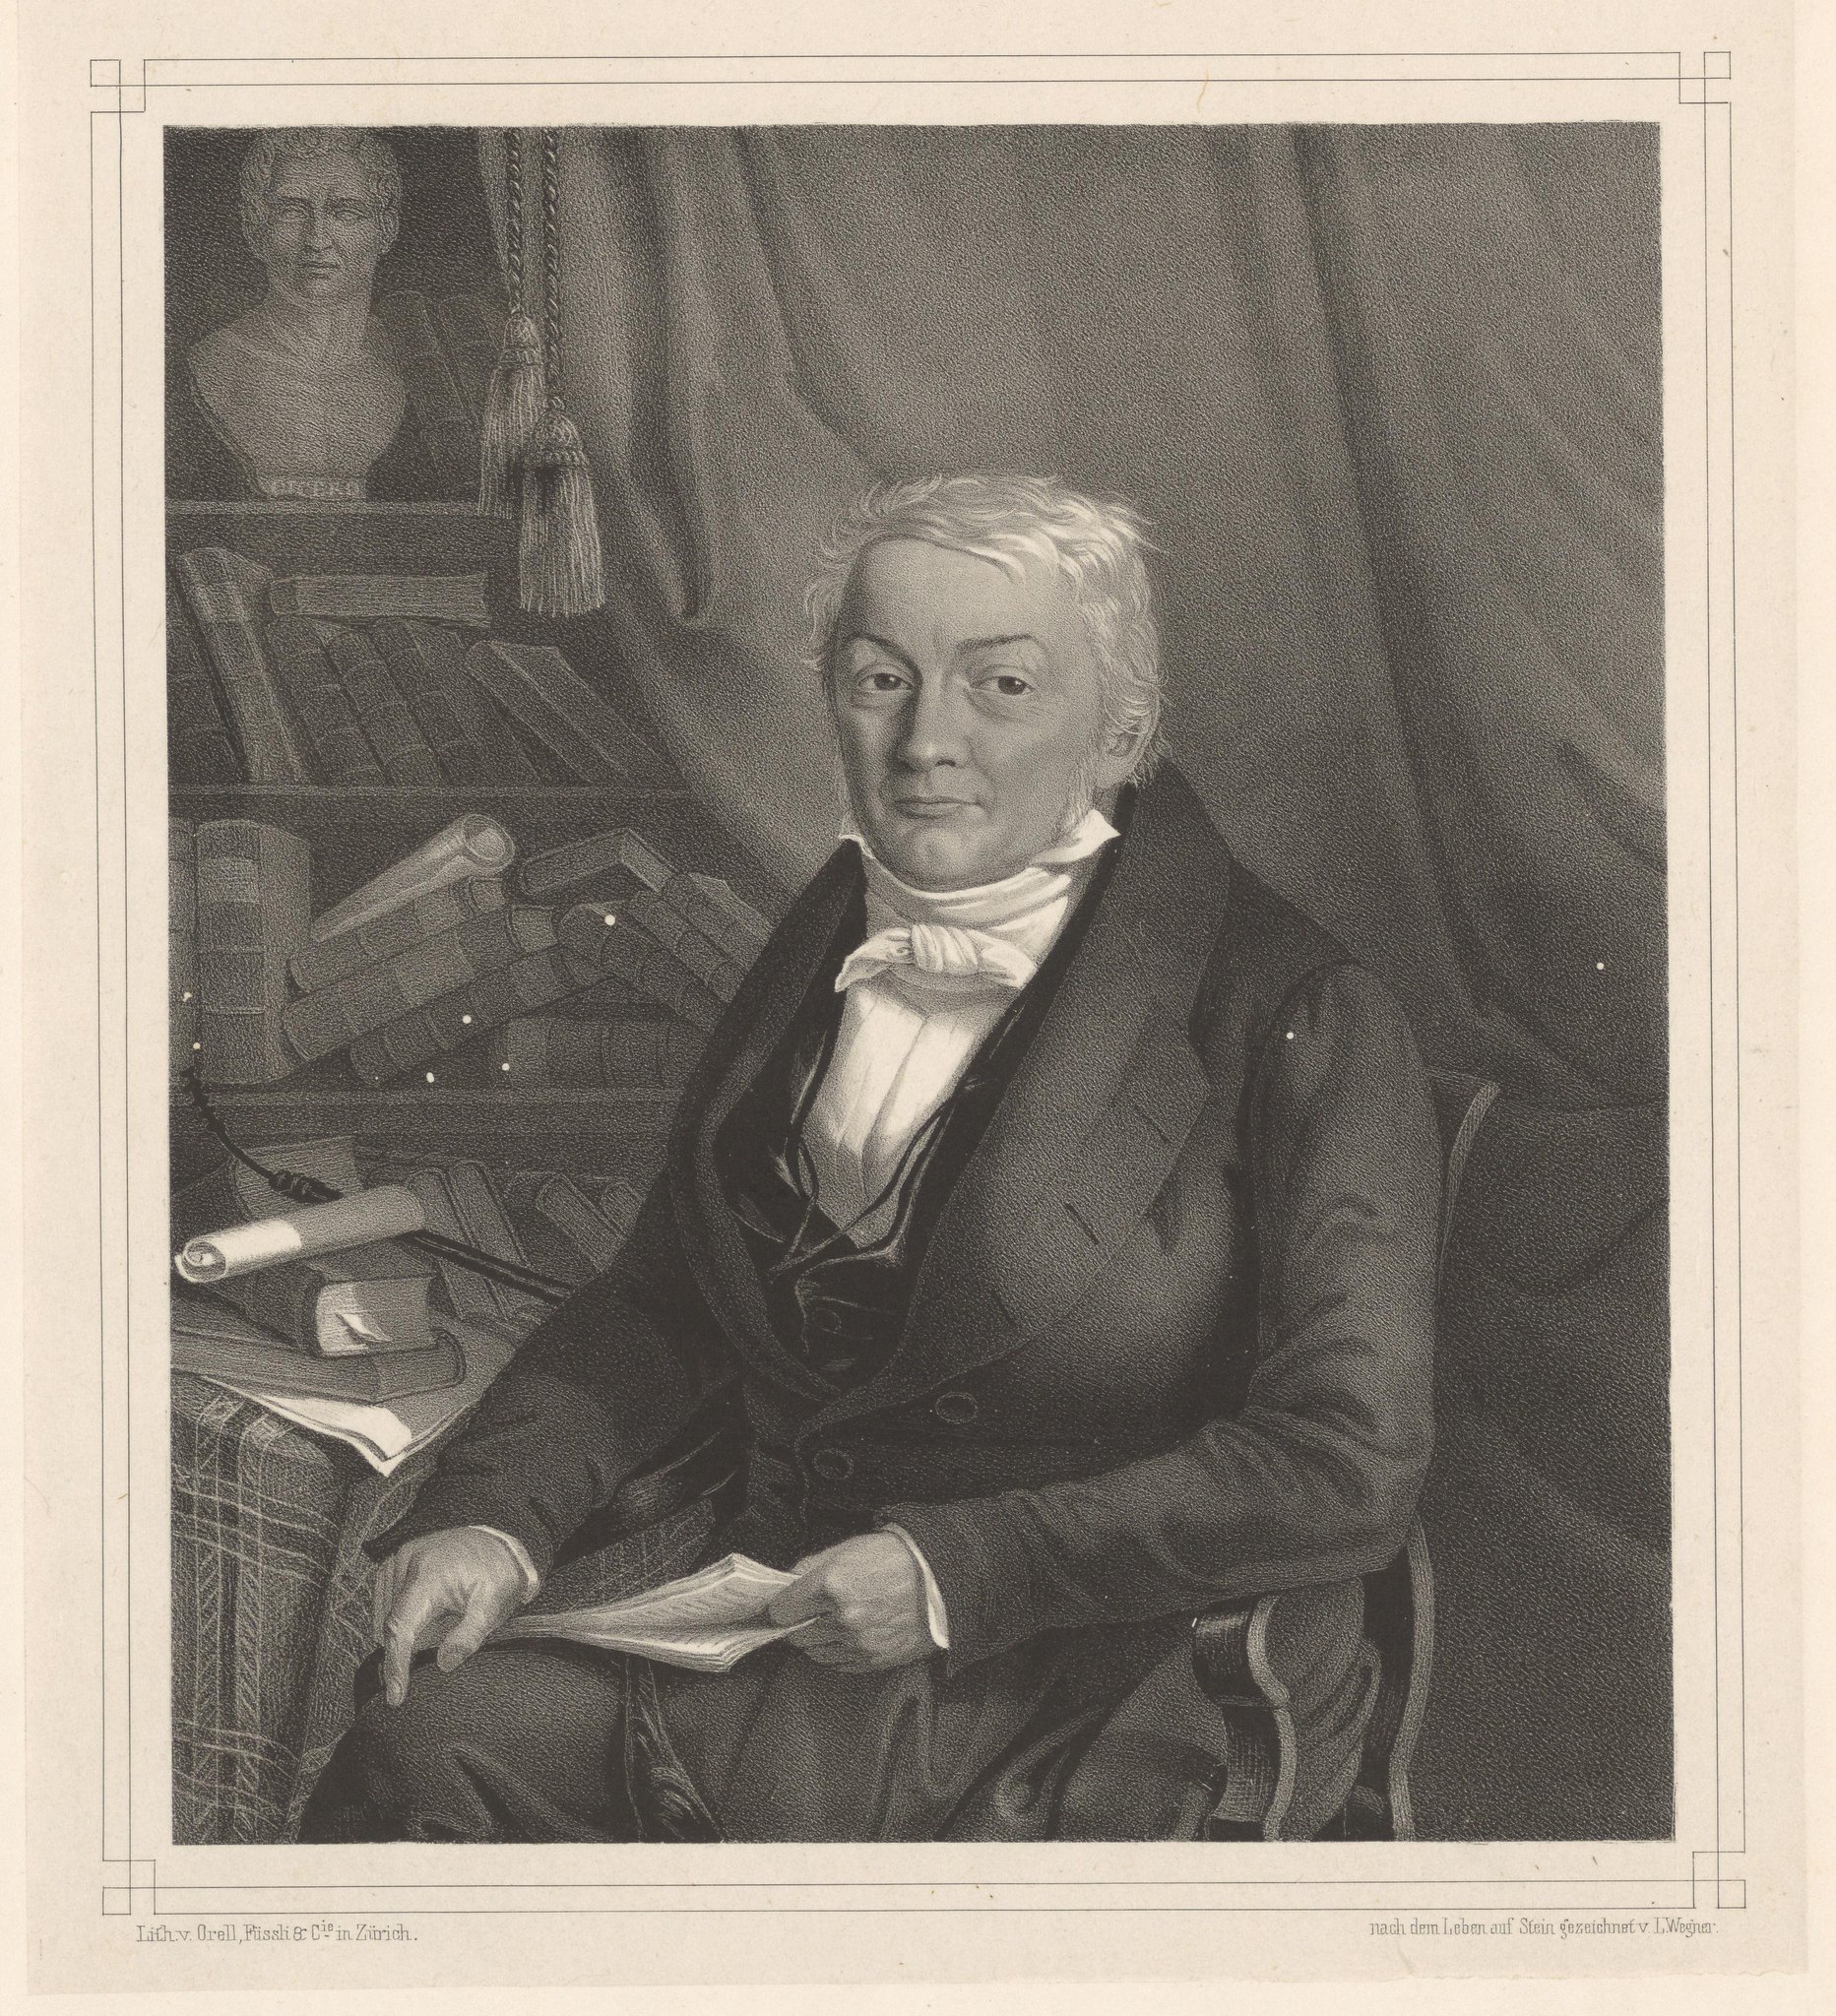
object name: print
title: Portret van Johann Caspar Orelli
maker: louis wegner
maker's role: print maker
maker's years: 1816-1864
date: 1832-1864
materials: paper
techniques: lithograph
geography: zurich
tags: bookshelves, adult man, historical persons, study; 'studiolo'; library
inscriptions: collector's mark: Lugt 2228